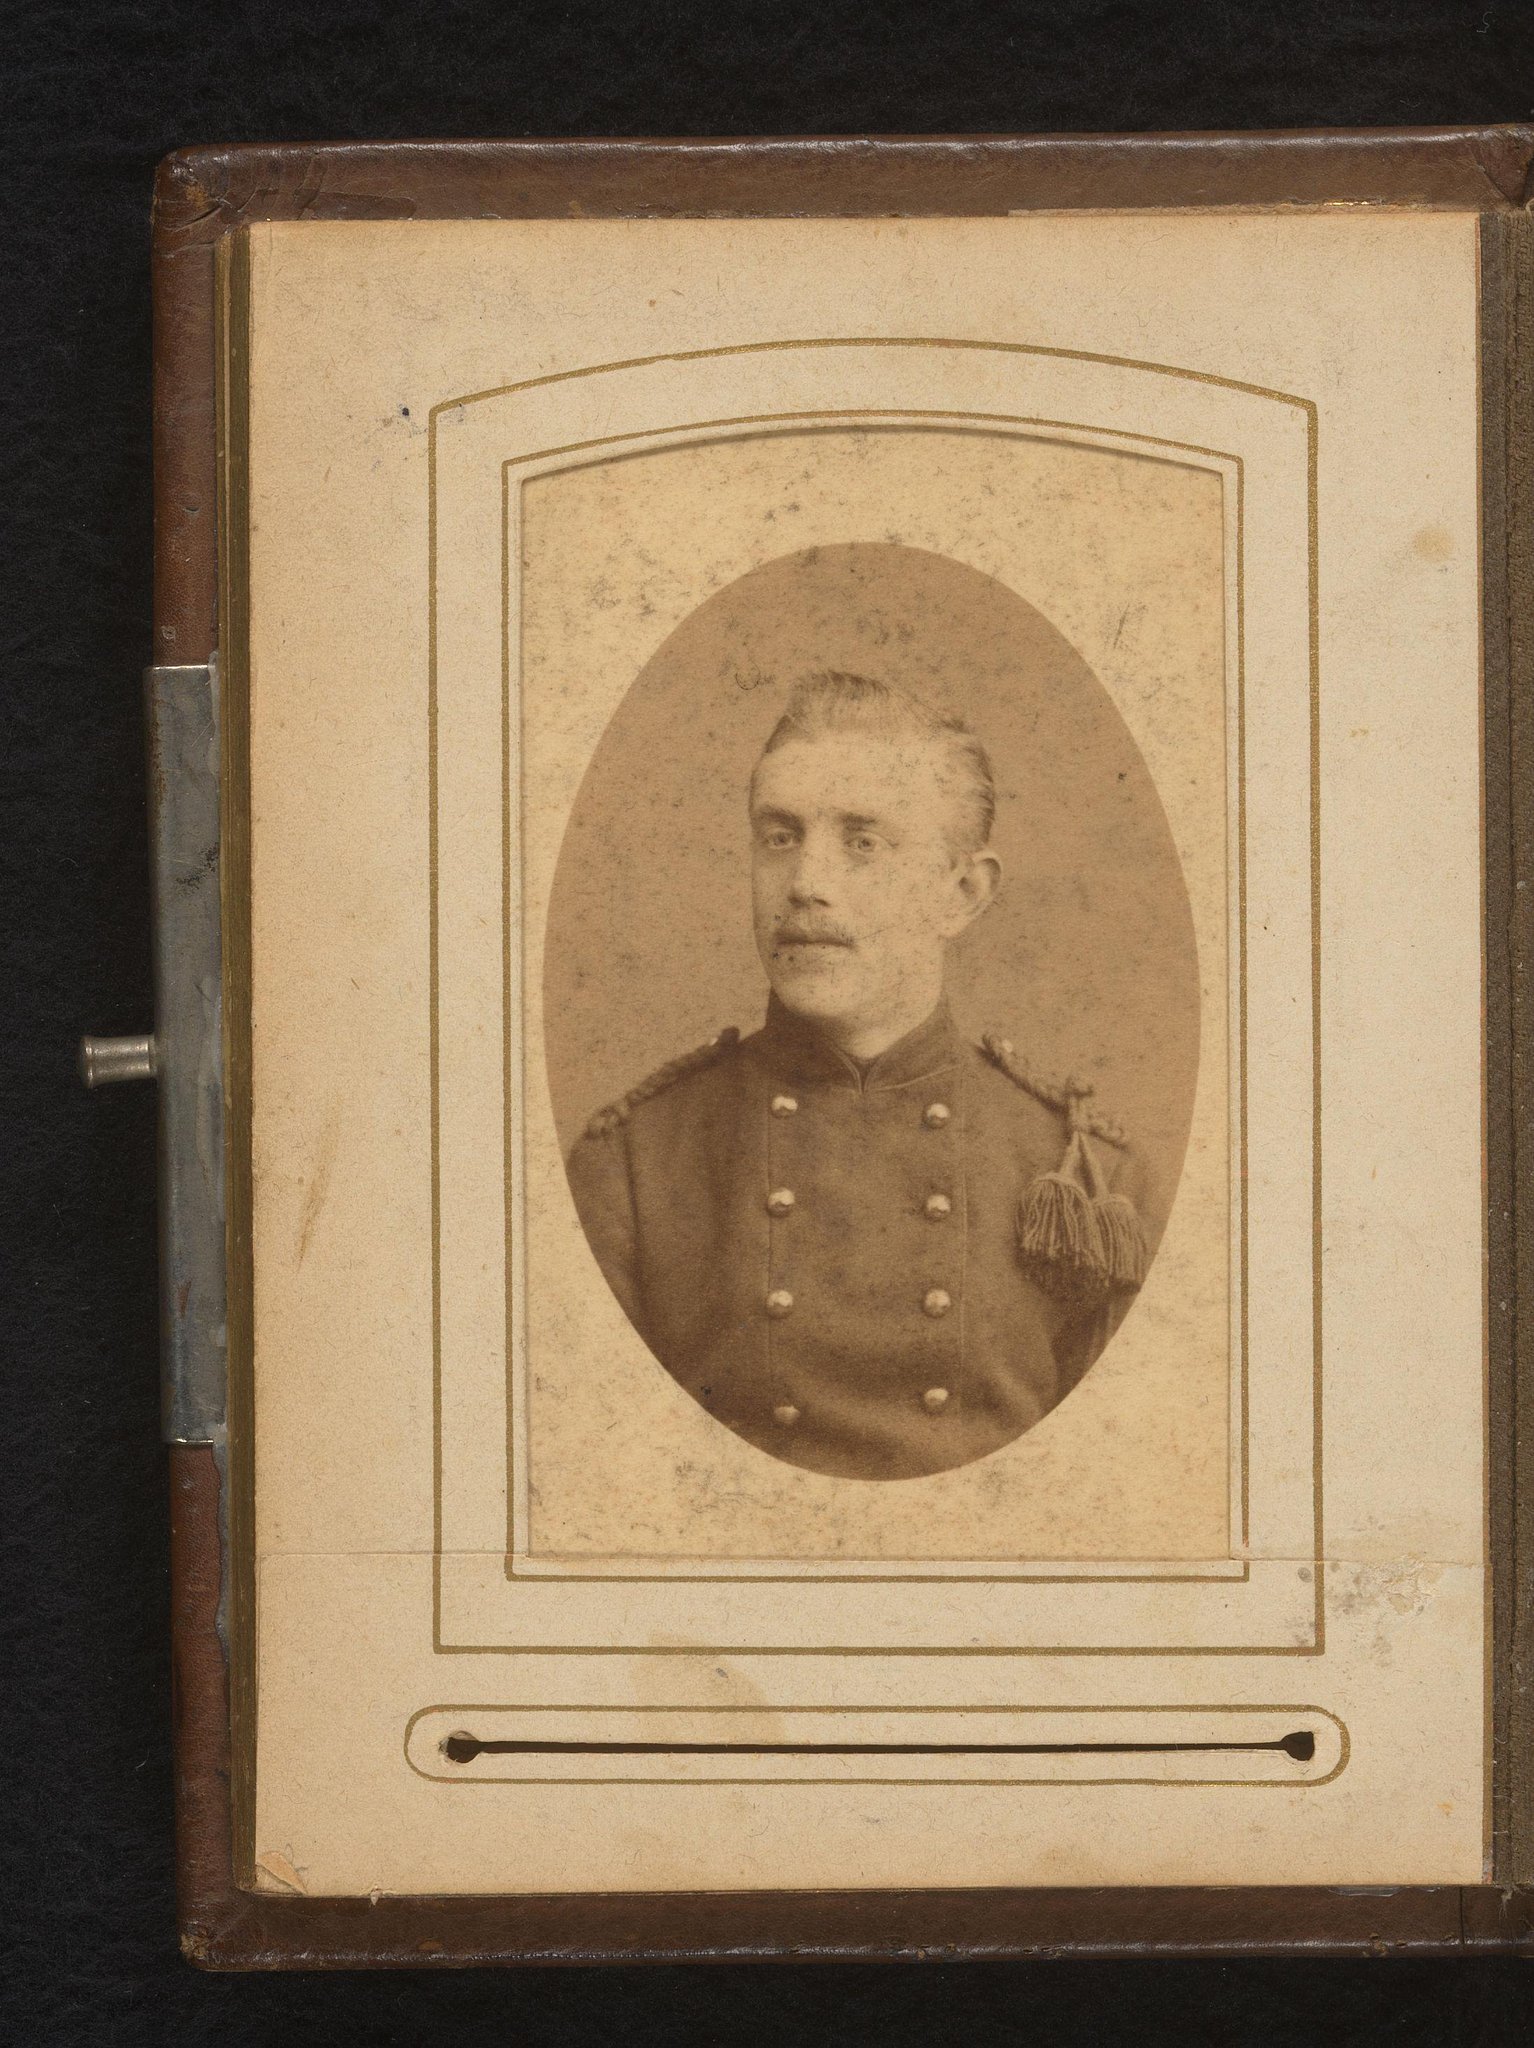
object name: album leaf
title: Portret van een man met snor in een uniform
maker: Anonymous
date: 1860-1900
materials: cardboard, photographic support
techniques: albumen print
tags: moustache, adult man, historical persons, (military) uniforms